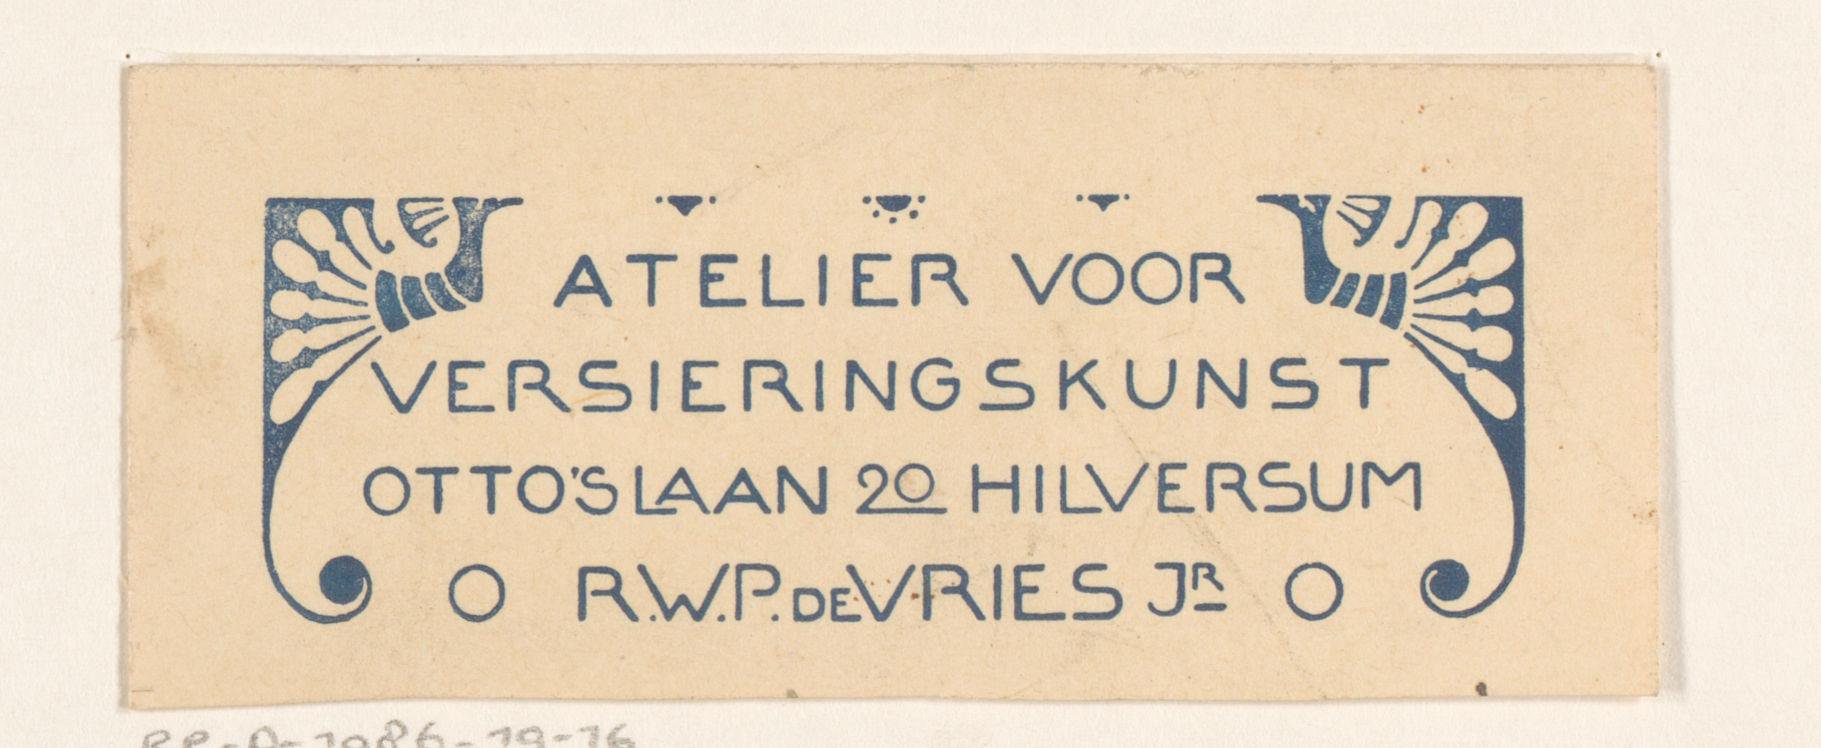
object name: print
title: Vignet van Atelier voor Versieringskunst te Hilversum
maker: reinier willem petrus de vries (1874-1953)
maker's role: draughtsman, print maker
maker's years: 1874-1953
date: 1884-1952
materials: paper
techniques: relief print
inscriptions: inscription: ‘AAN’, collector's mark: ‘R:MVS.’